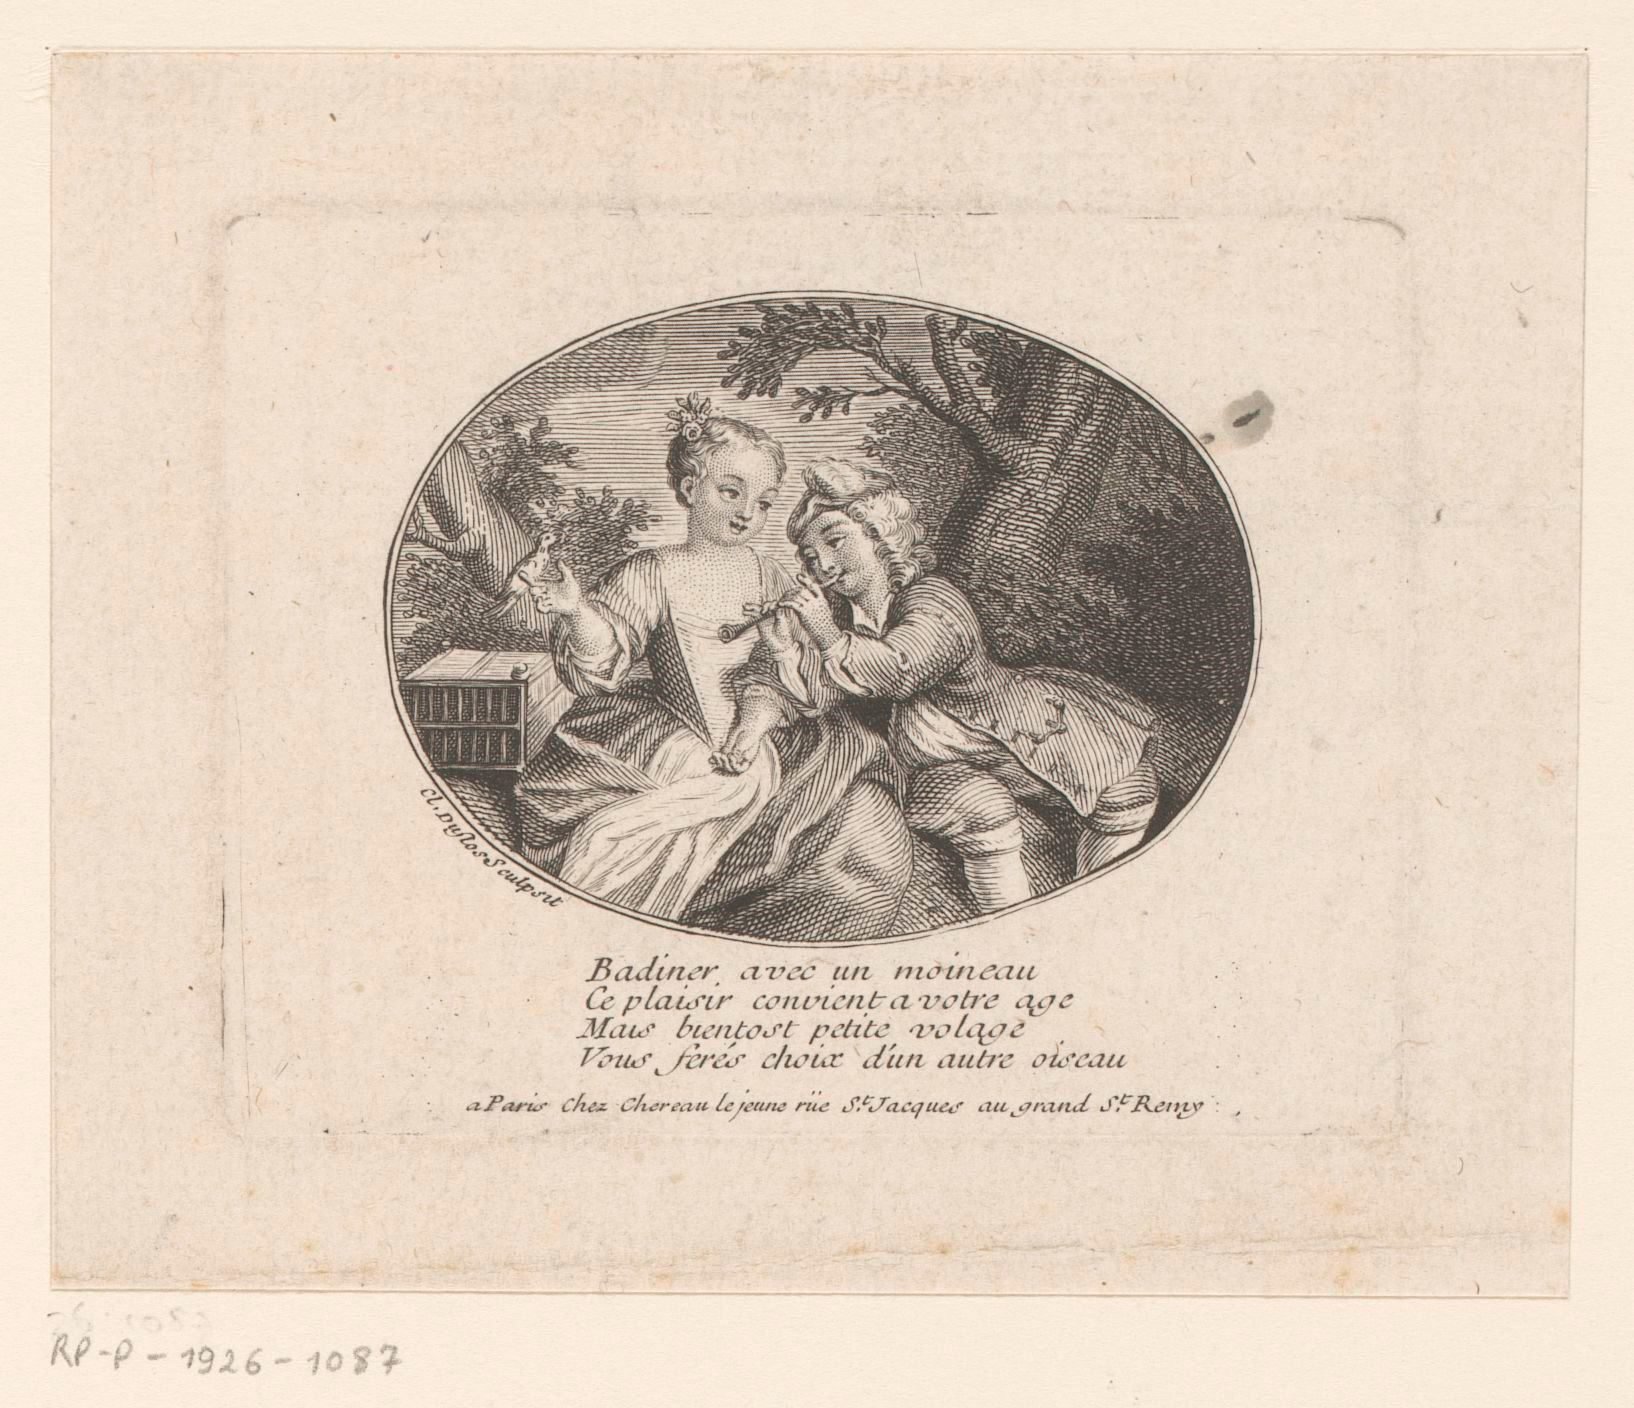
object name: print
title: Zinnespelende scène met jongen spelend op fluit en meisje met vogel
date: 1727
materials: paper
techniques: engraving, etching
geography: france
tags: boy (child between toddler and youth), bird-cage opened (loss of virginity symbolized), flute, aulos, tibia - cc - out of doors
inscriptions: collector's mark: Lugt 2228